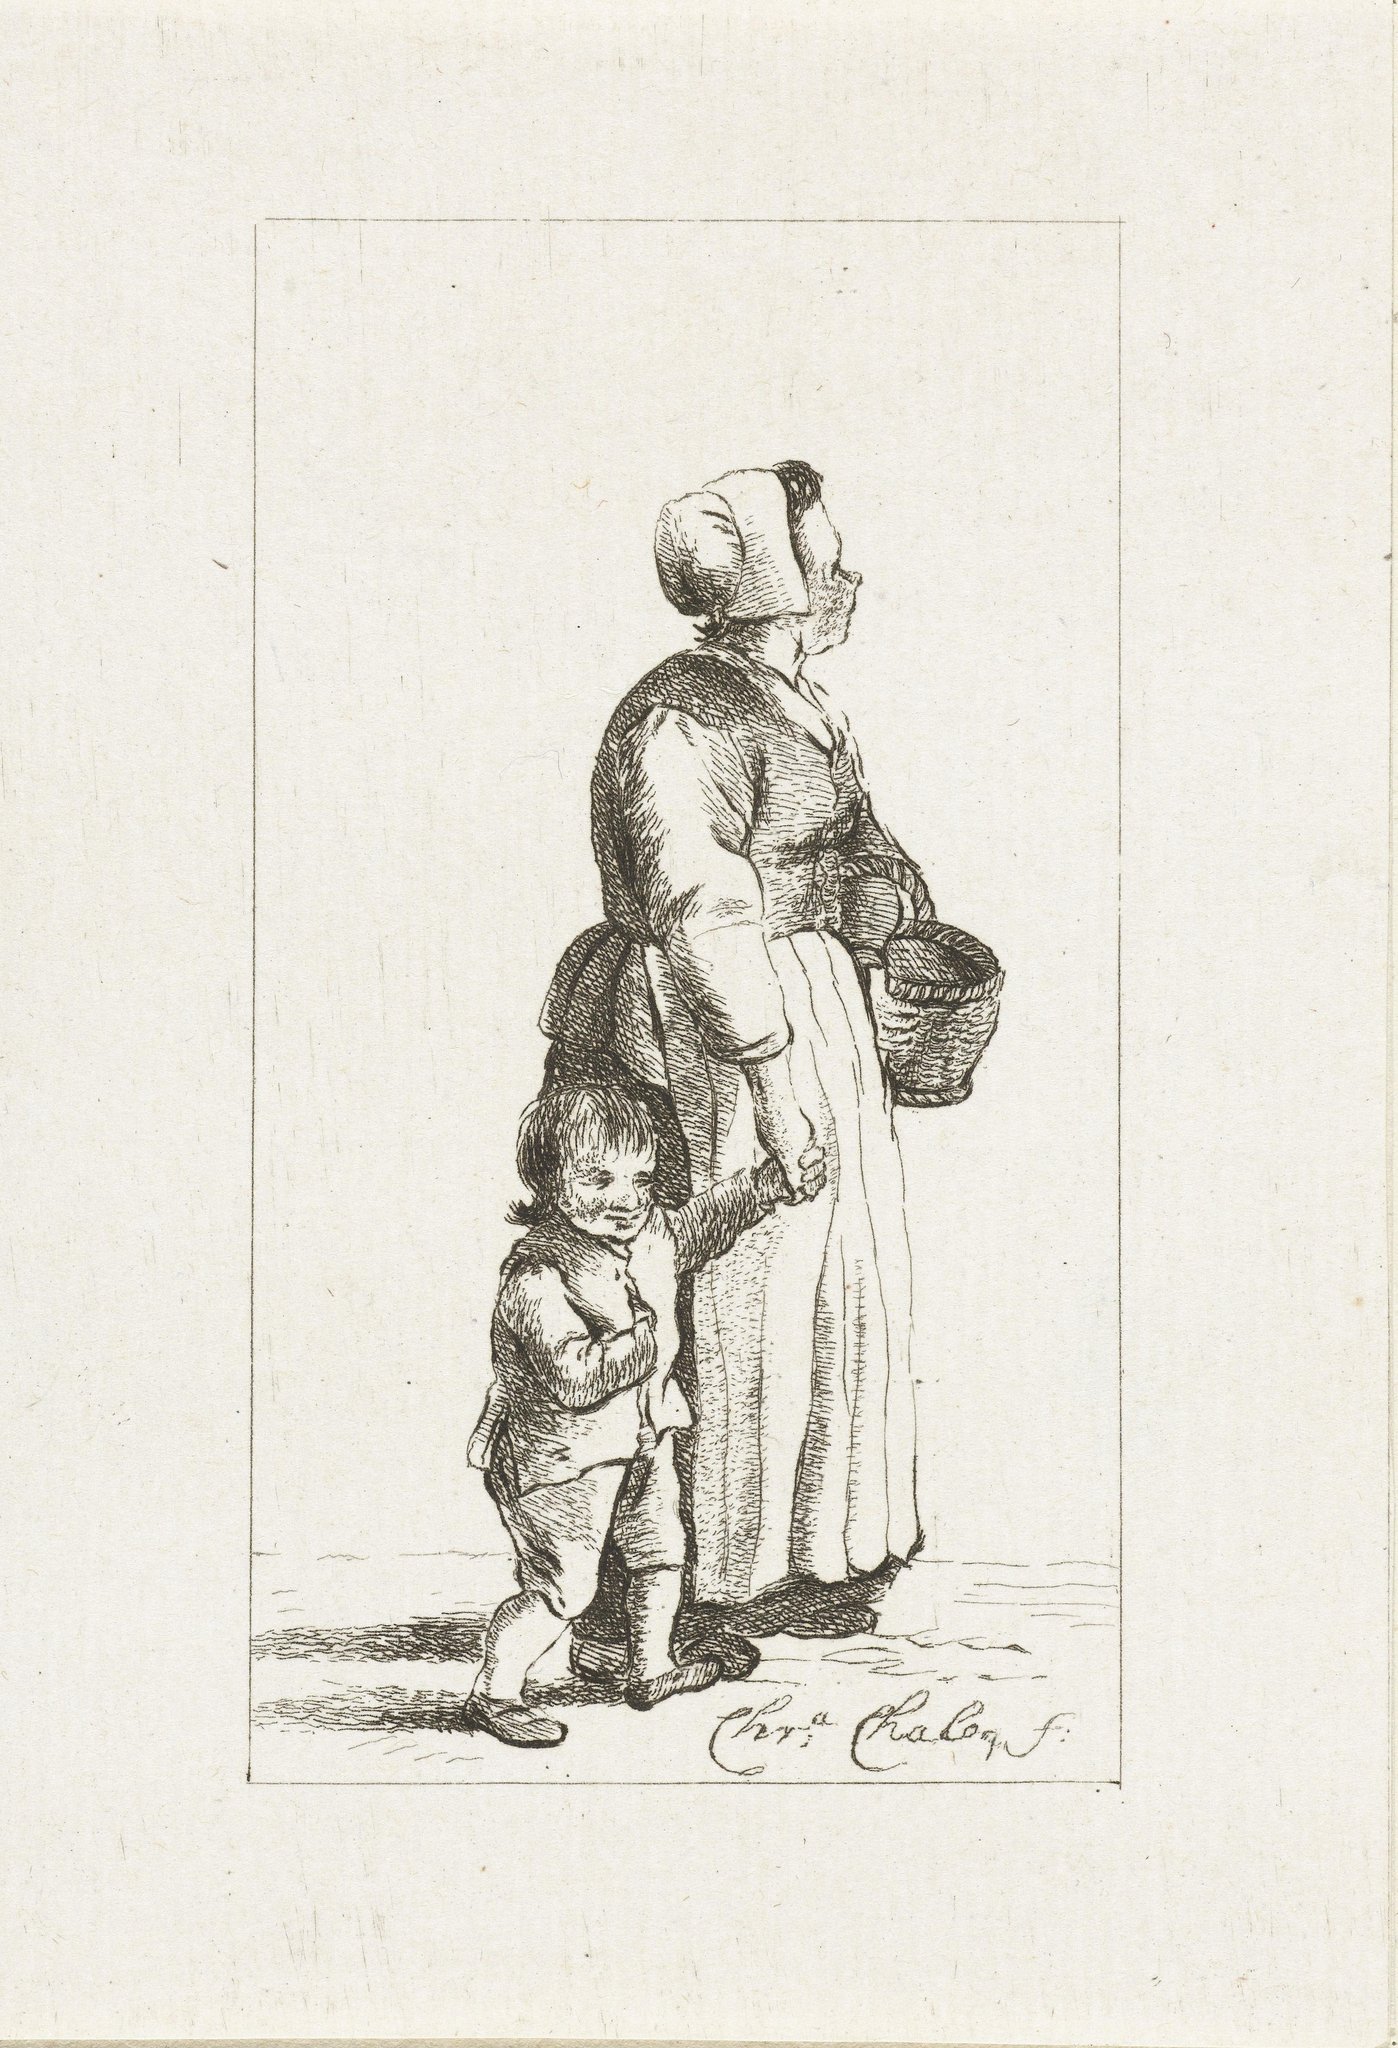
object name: print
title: Staande vrouw met kind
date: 1779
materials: paper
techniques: etching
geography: leiden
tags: carrying something in basket, bag, rucksack, etc., mother and child(ren), woman and child(ren) (family group) (with number of children)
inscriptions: collector's mark: Lugt 2233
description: Een moeder met haar zoontje. Lopend naar rechts. De moeder draagt een mandje in de andere hand.